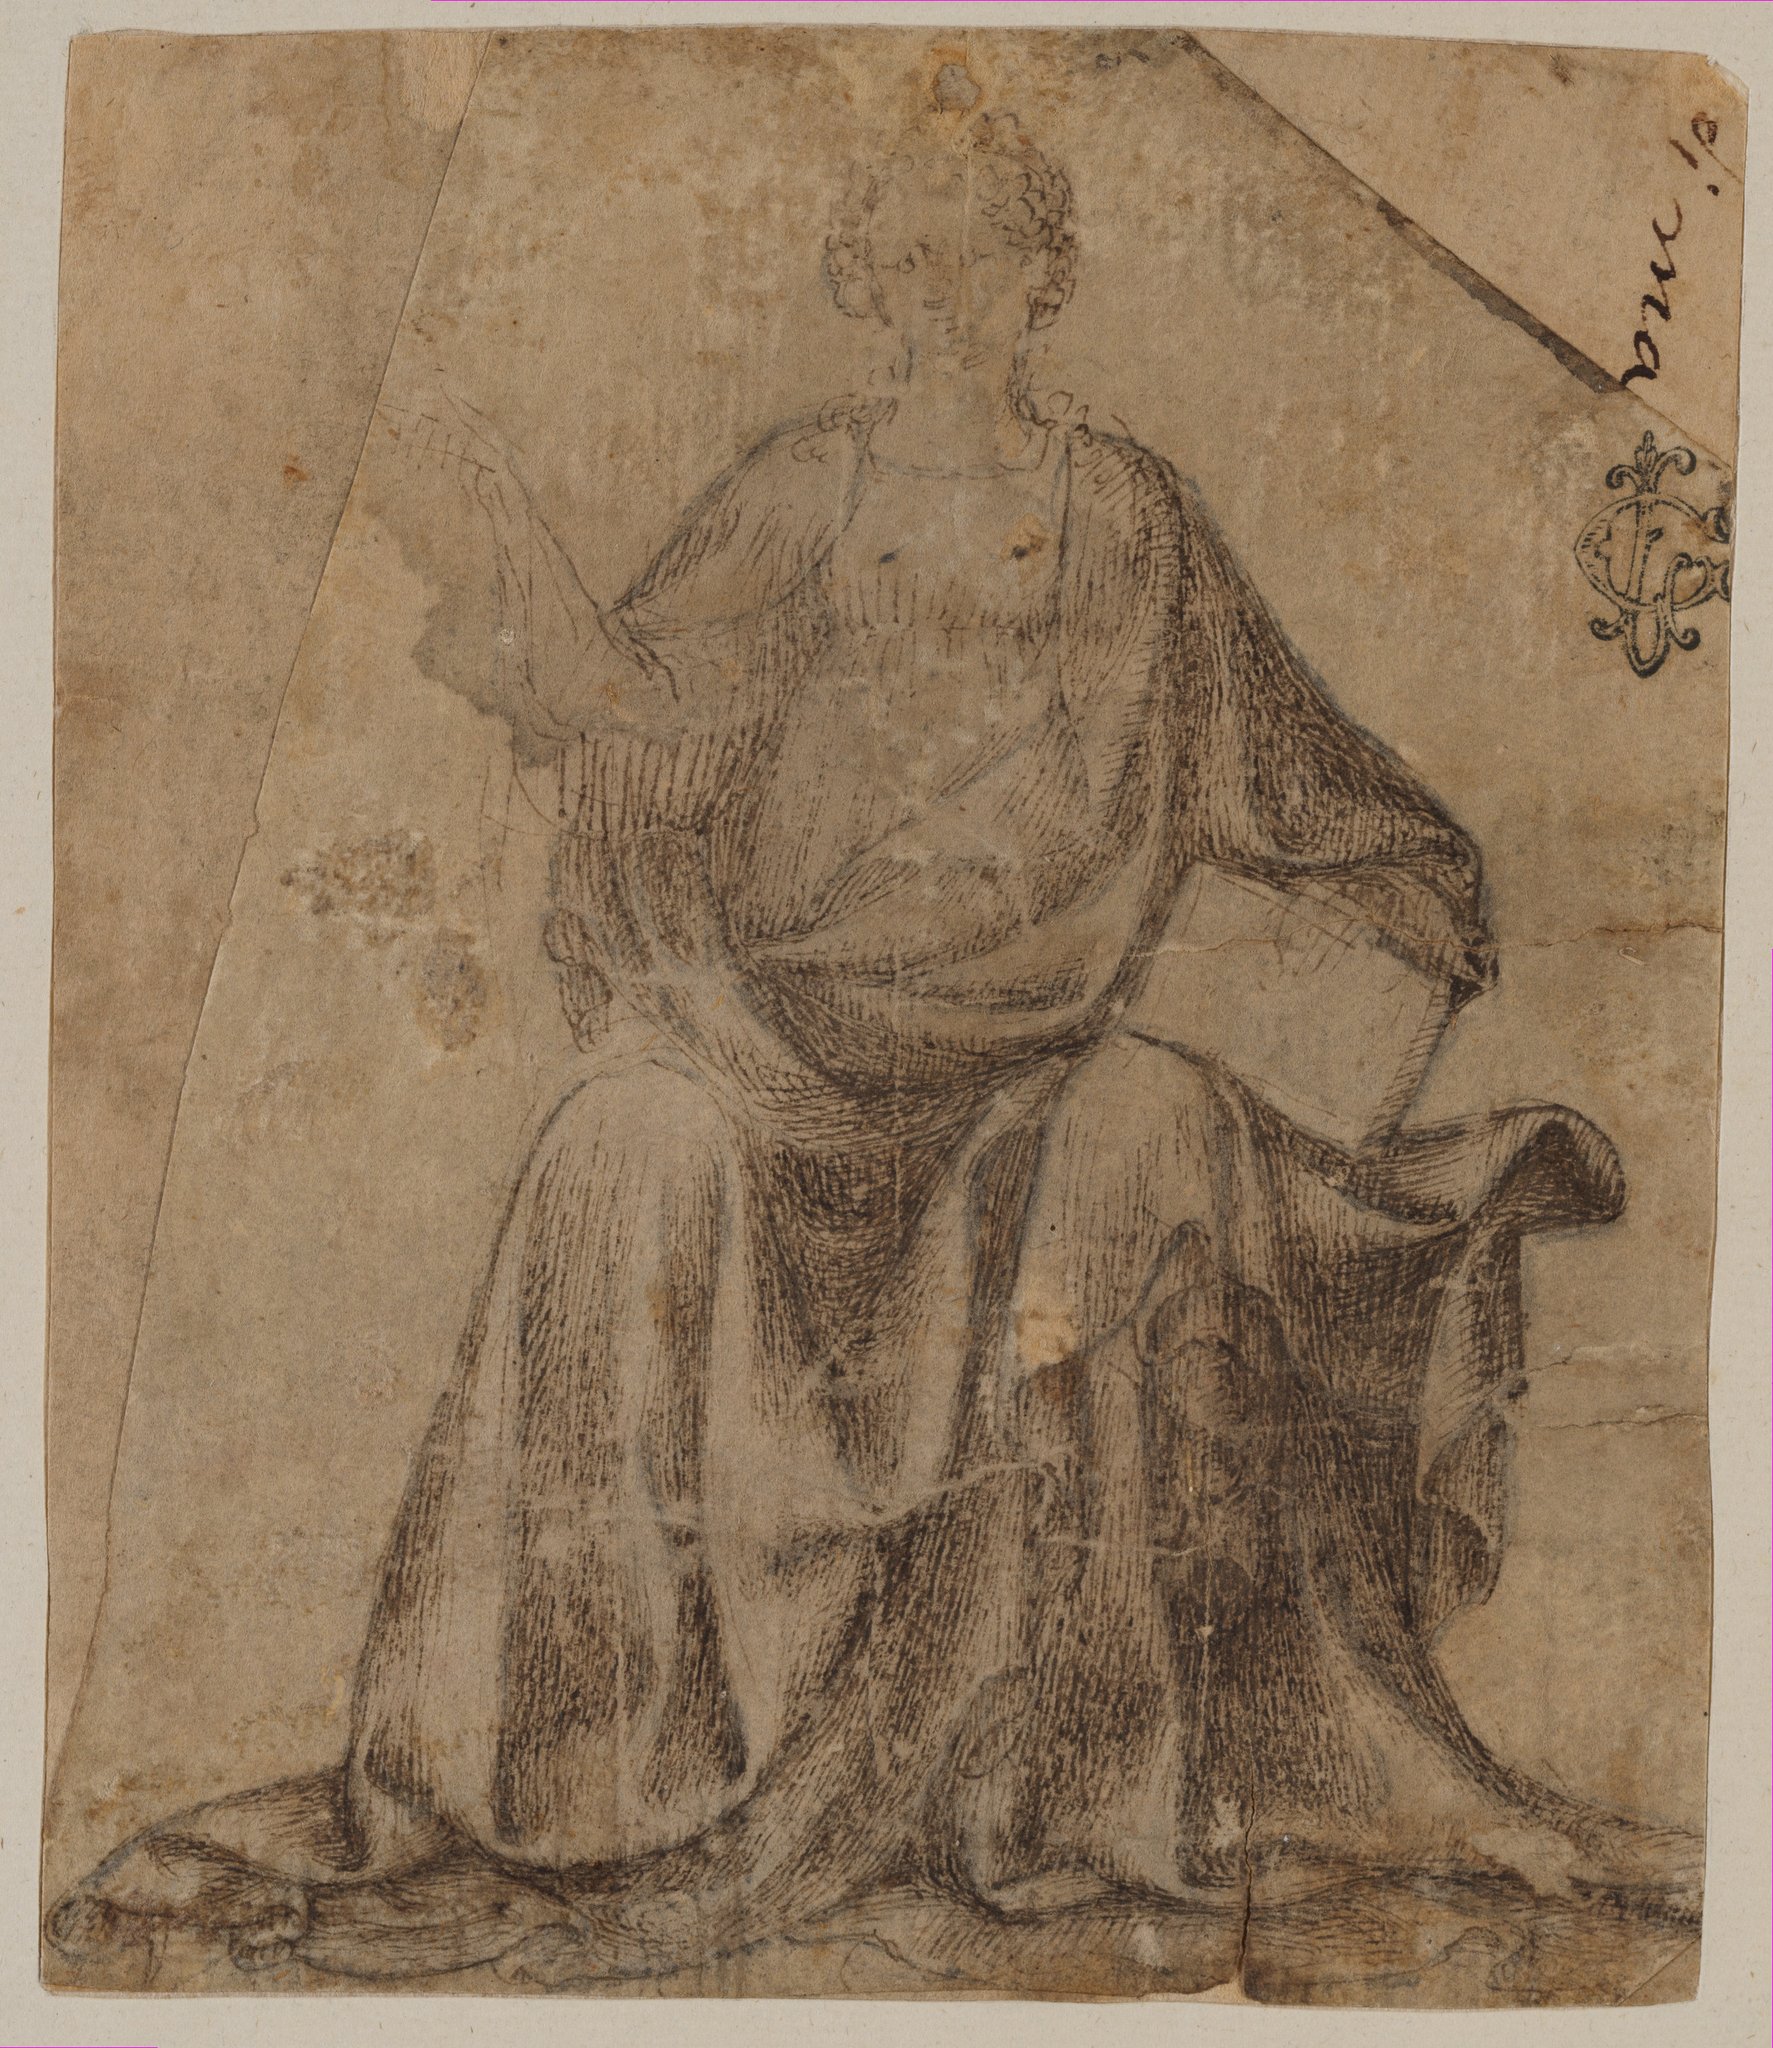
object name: drawing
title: Seated Female Figure Holding a Book and a Scroll (?)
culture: italian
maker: veronese school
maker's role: artist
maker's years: 1430-1469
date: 1434-1466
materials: chalk, ink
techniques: pen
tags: books,portraits,women